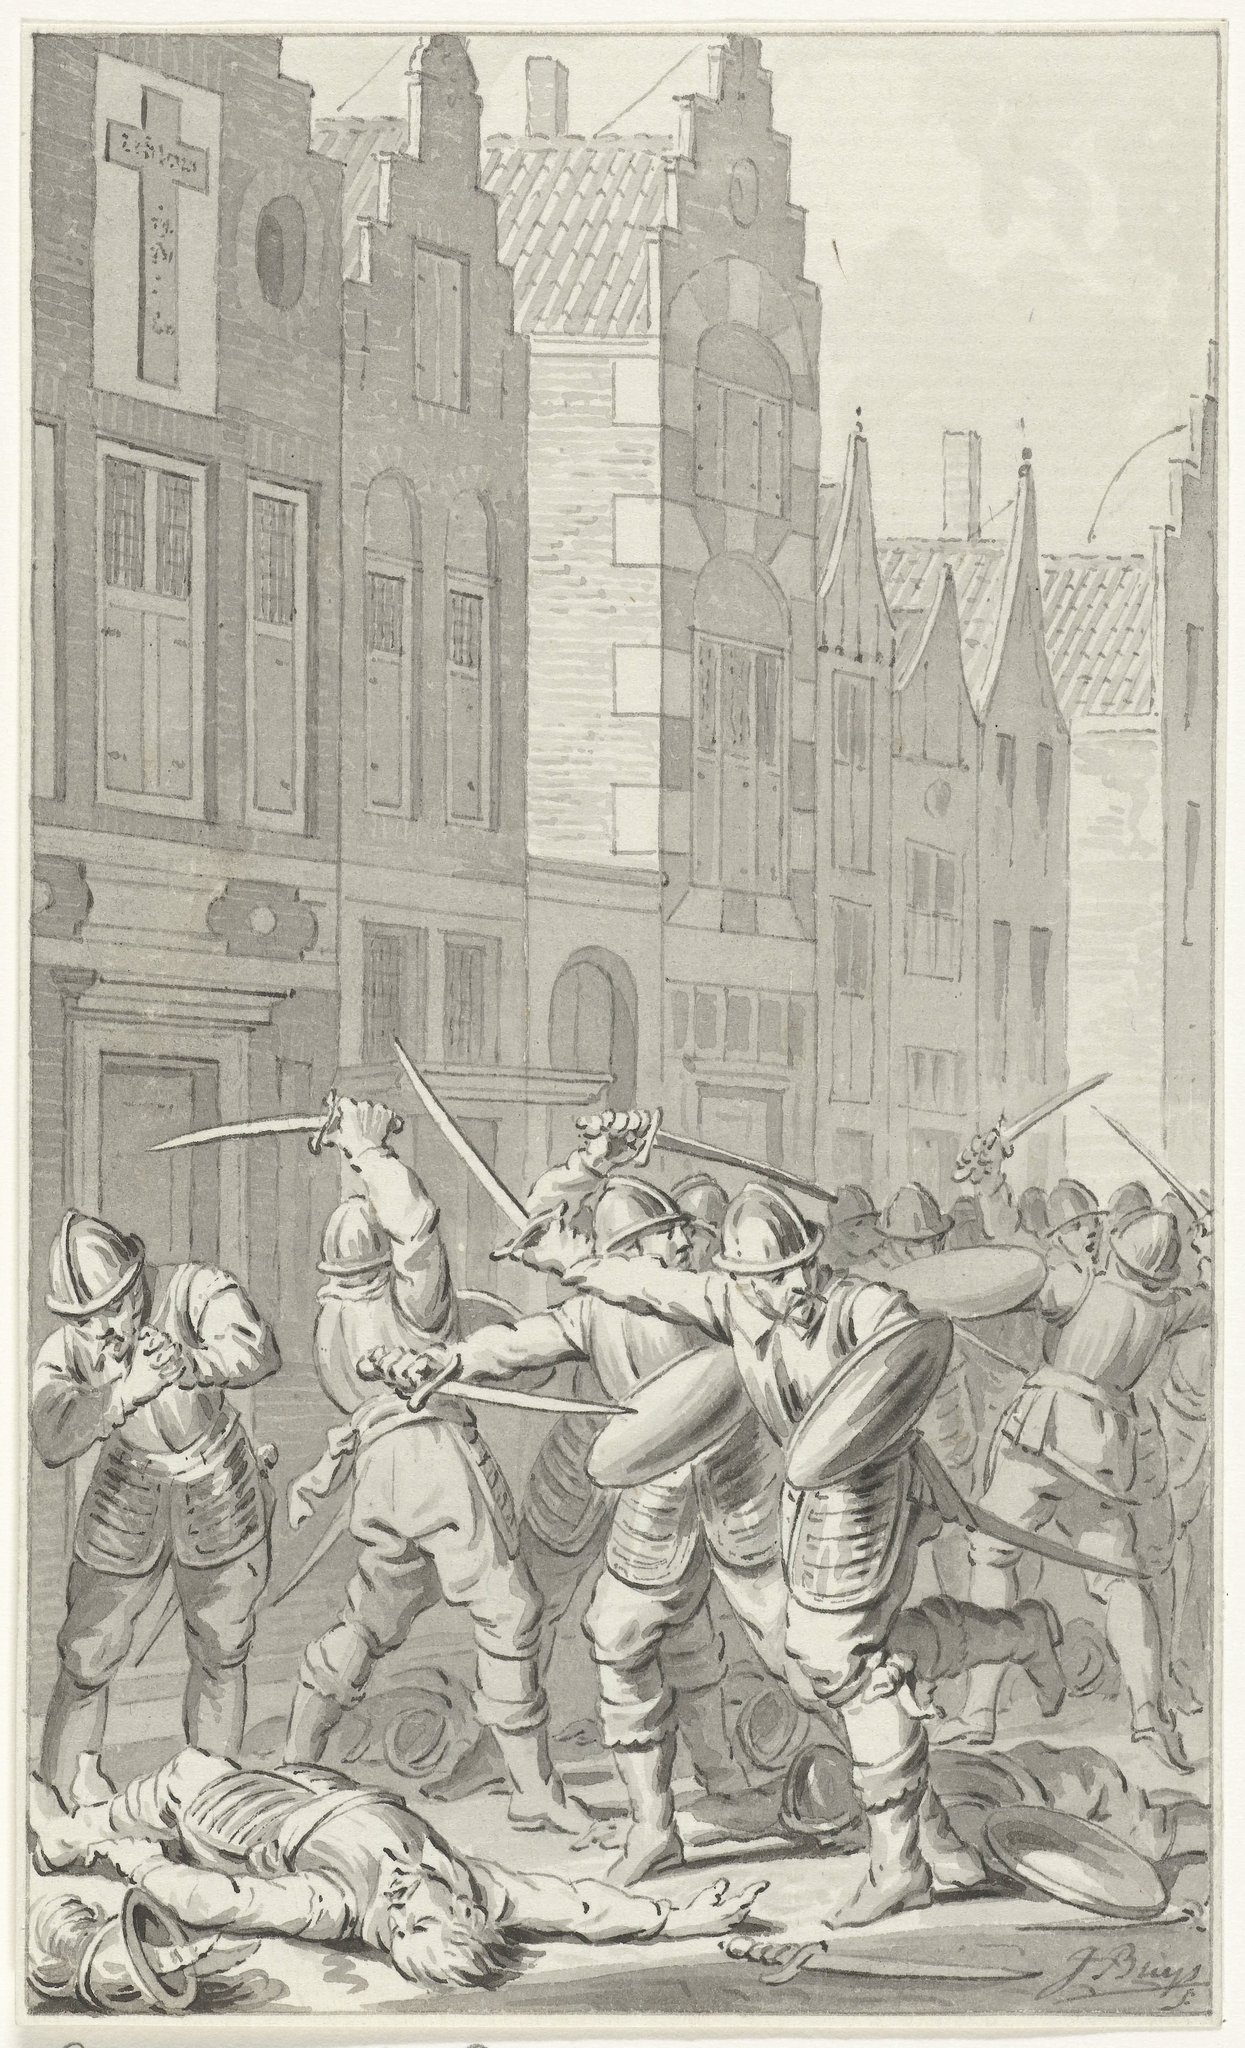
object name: drawing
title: Willem van Arkel sneuvelt in de Krijtsteeg te Gorinchem, 1 december 1417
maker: jacobus buys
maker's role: draughtsman, print maker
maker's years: 1724-1801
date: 1786-1788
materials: ink, paper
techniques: brush, pen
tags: putting out of action by killing - hh - being put out of action, historical persons, violent death, being killed; being mishandled and maltreated; seeking death, historical events and situations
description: Ontwerptekening voor illustratie in: Jacobus Kok, Vaderlandsch Woordenboek, Johannes Allart, Amsterdam 1785-1799, 35 delen, dl. XVIII, pl. III.